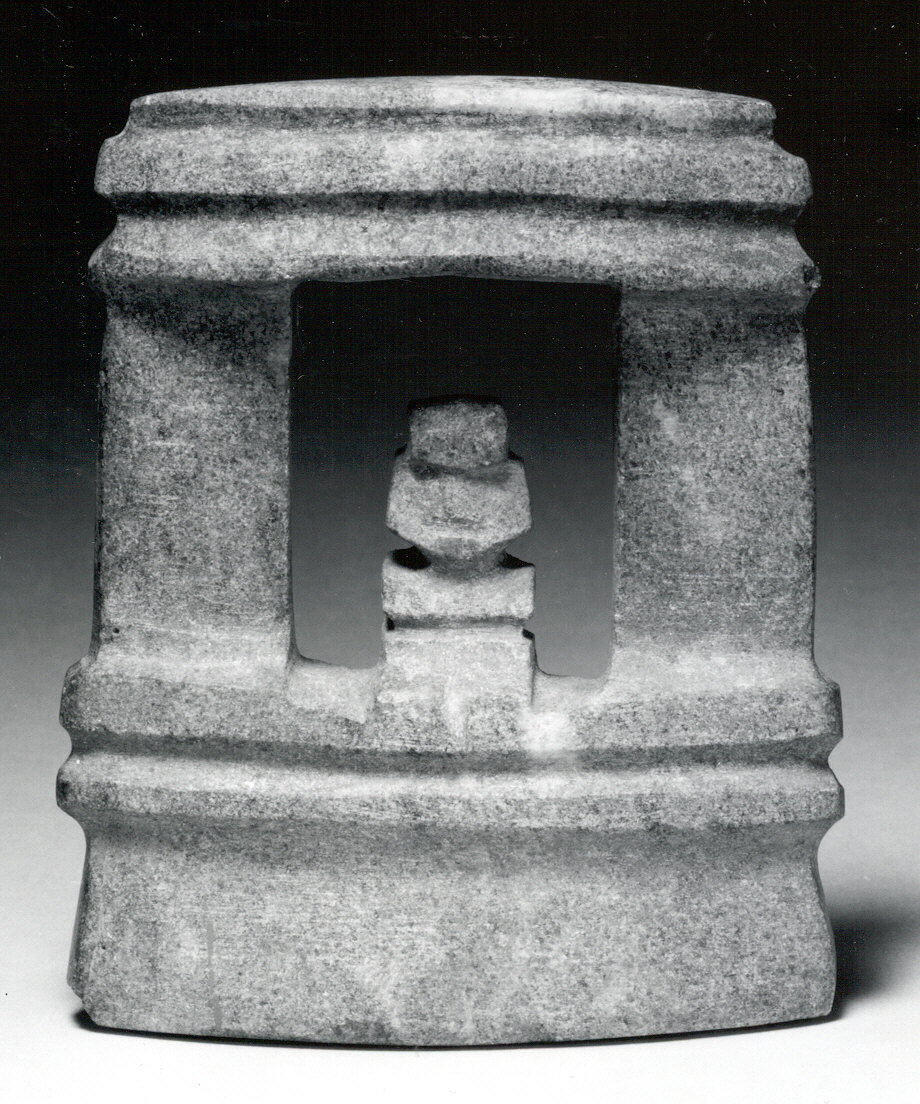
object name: architectural model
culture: mezcala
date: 1-800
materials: stone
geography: mexico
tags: temples